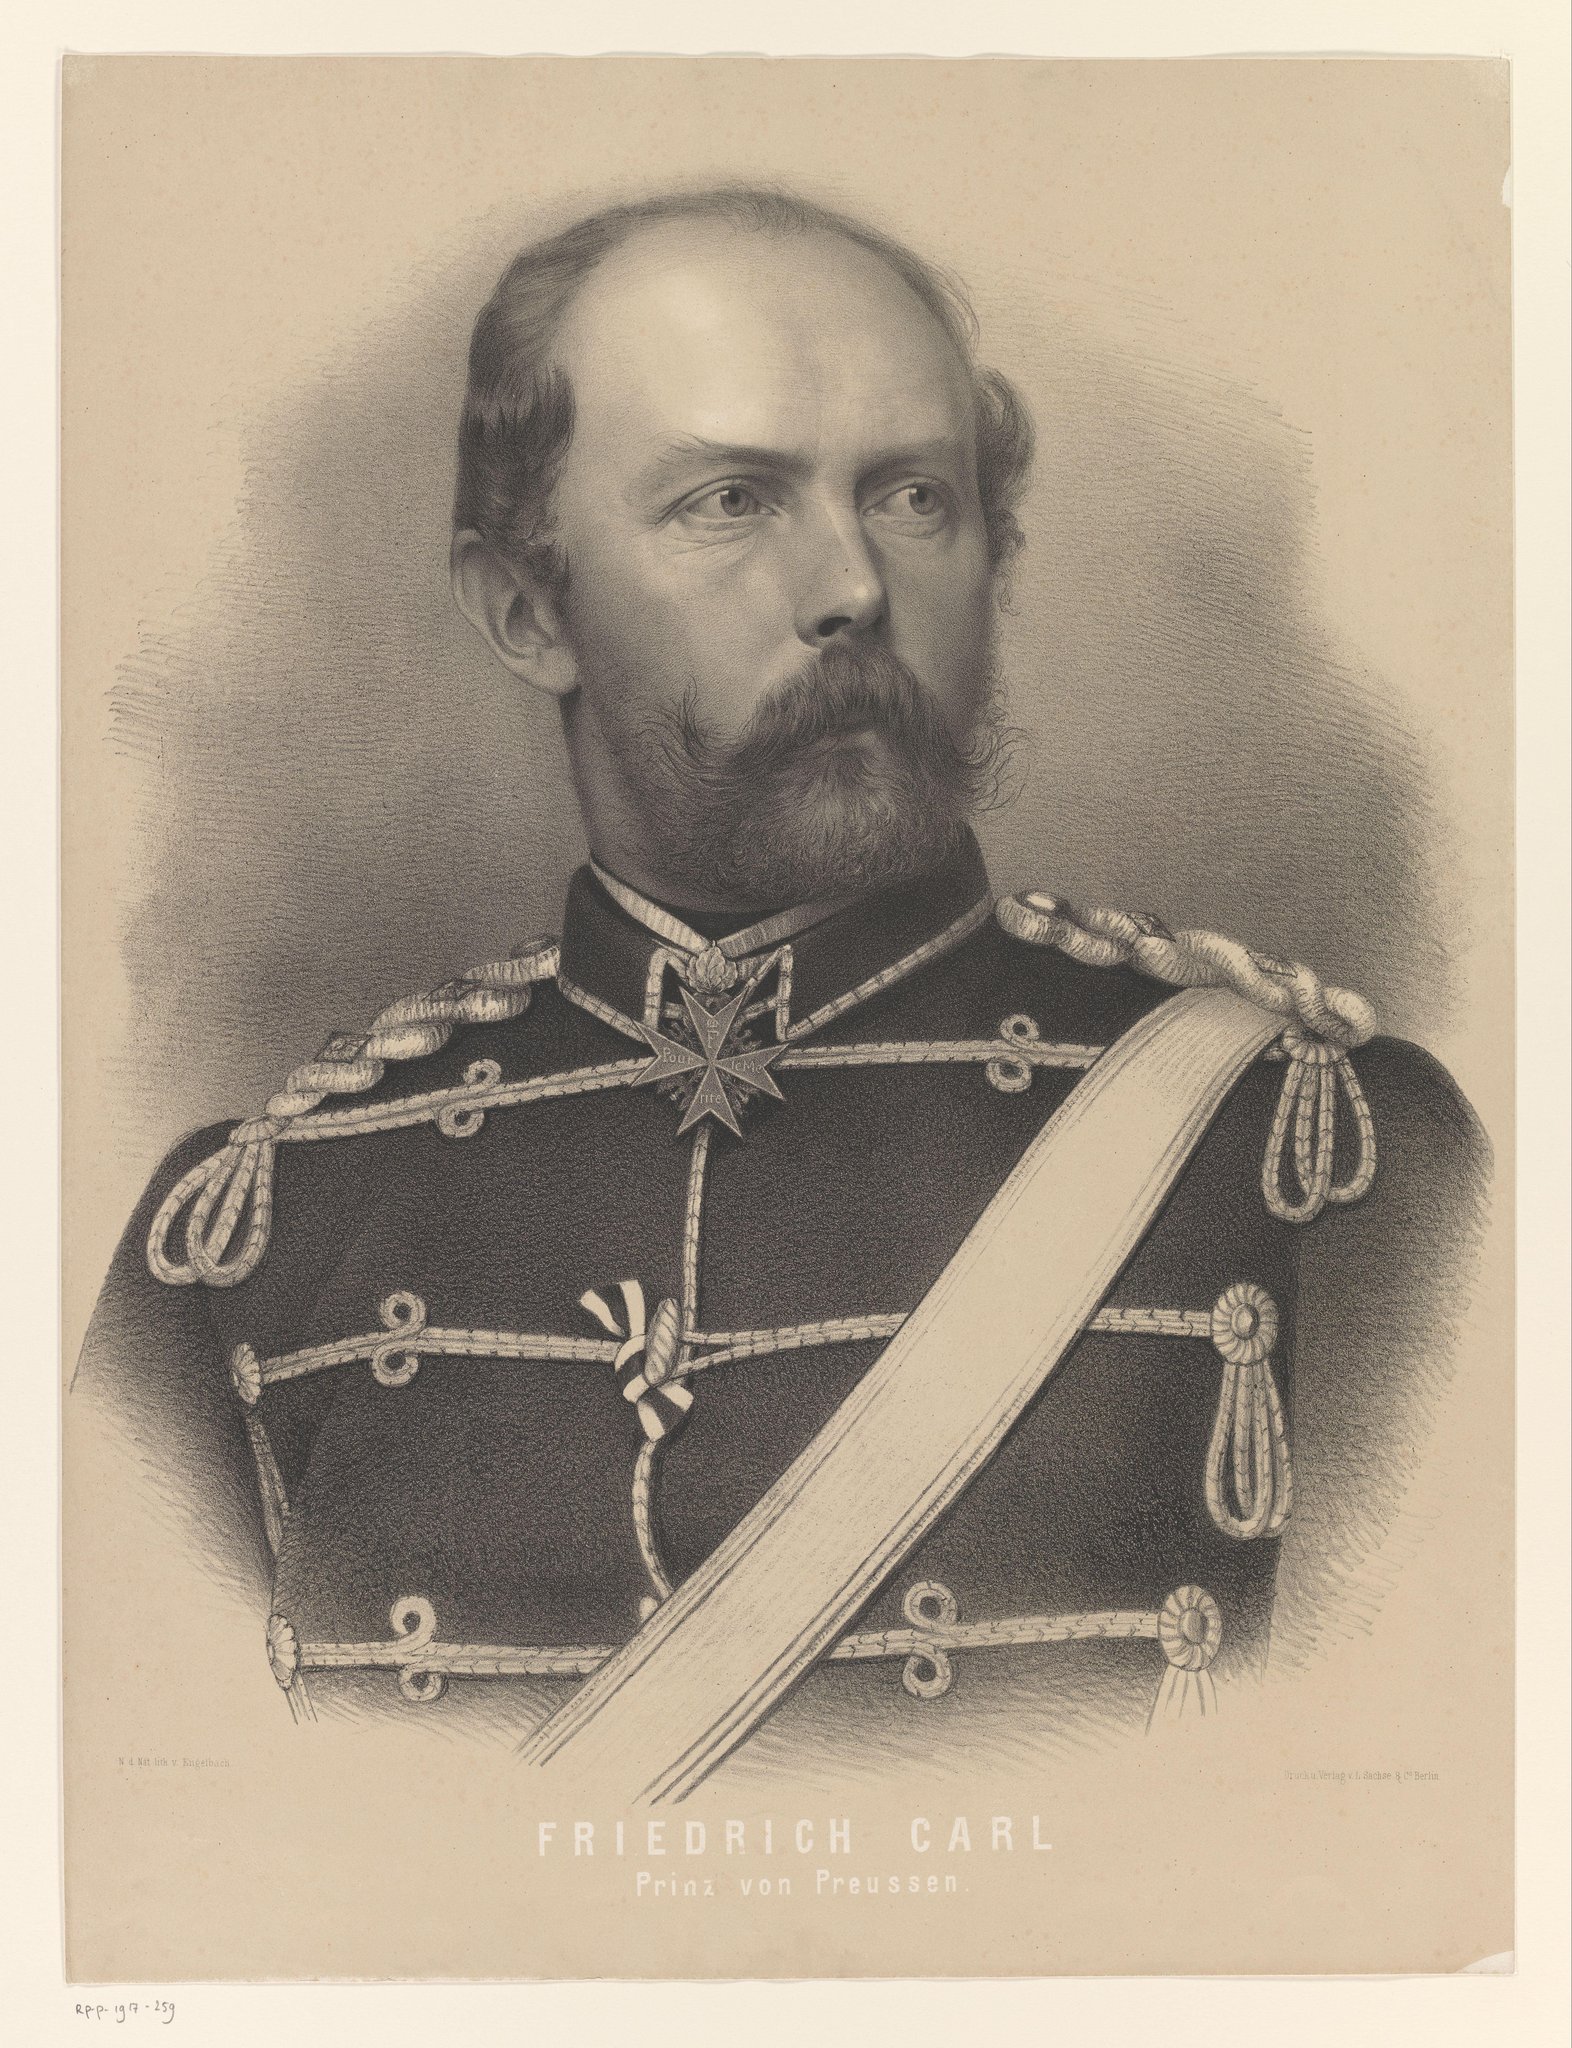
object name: print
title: Friedrich Carl, Prinz von Preussen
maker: georg engelbach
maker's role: print maker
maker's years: 1817-1890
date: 1827-1890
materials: paper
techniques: tone lithography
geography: berlin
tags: berlin, adult man, historical persons, beard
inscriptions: collector's mark: Lugt 2228